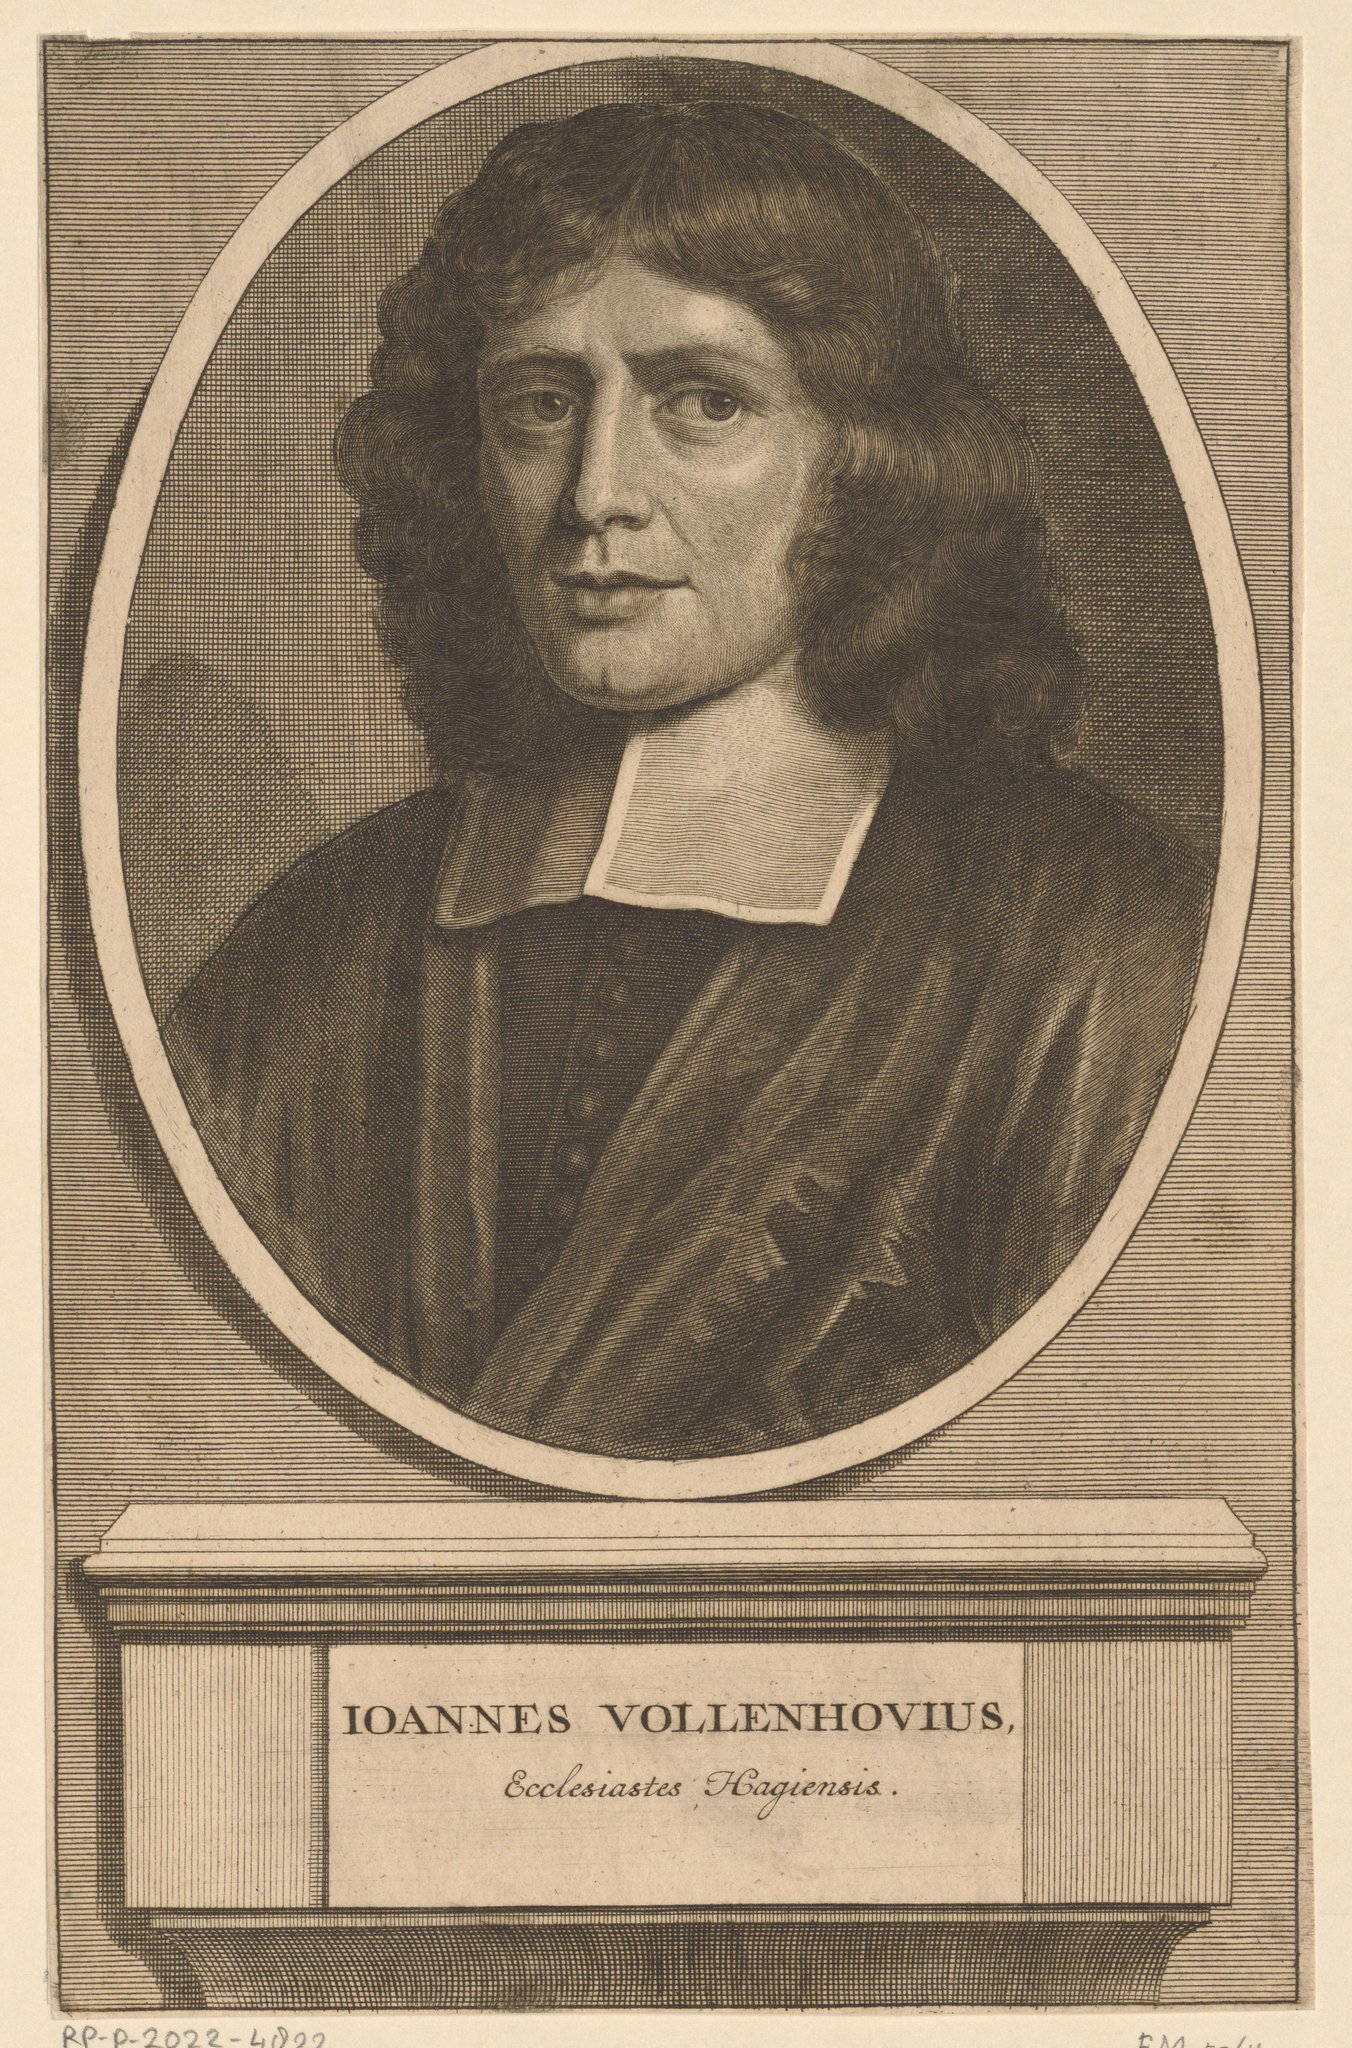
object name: print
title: Negentien portretten van theologen en filologen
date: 1720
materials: paper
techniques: engraving, etching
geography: amsterdam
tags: the hague, theologian, historical persons, writer, poet, author